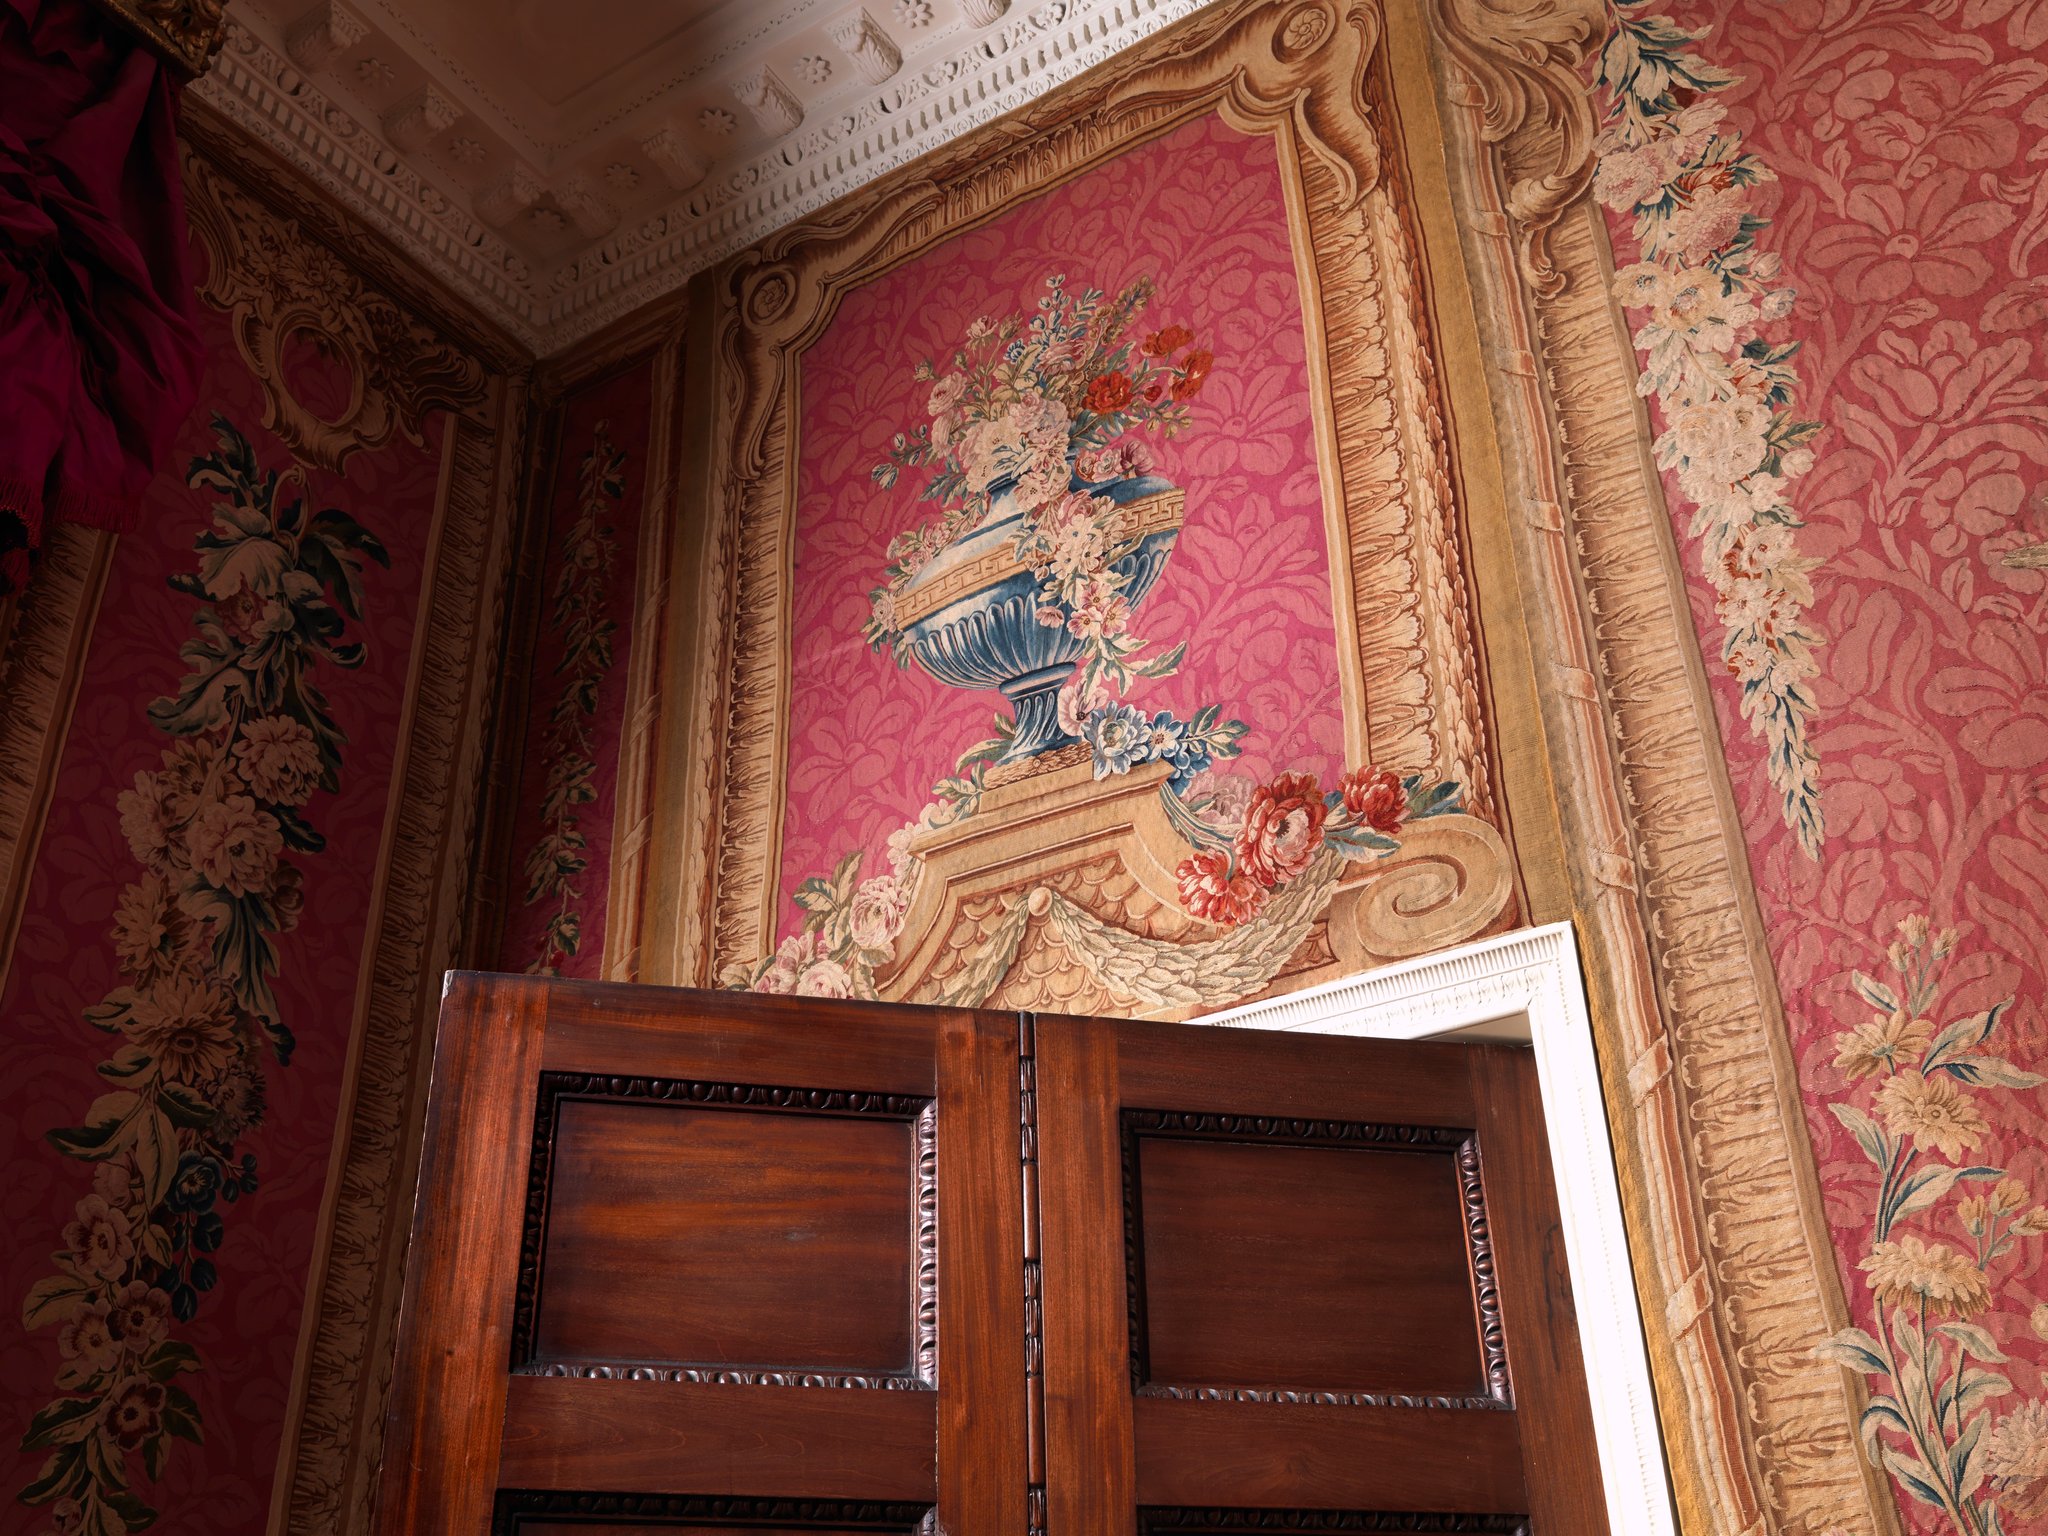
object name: tapestry panel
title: Two overdoor panels with vases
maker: jacques germain soufflot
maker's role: designer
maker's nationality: french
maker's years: 1713-1780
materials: silk, wool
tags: flowers